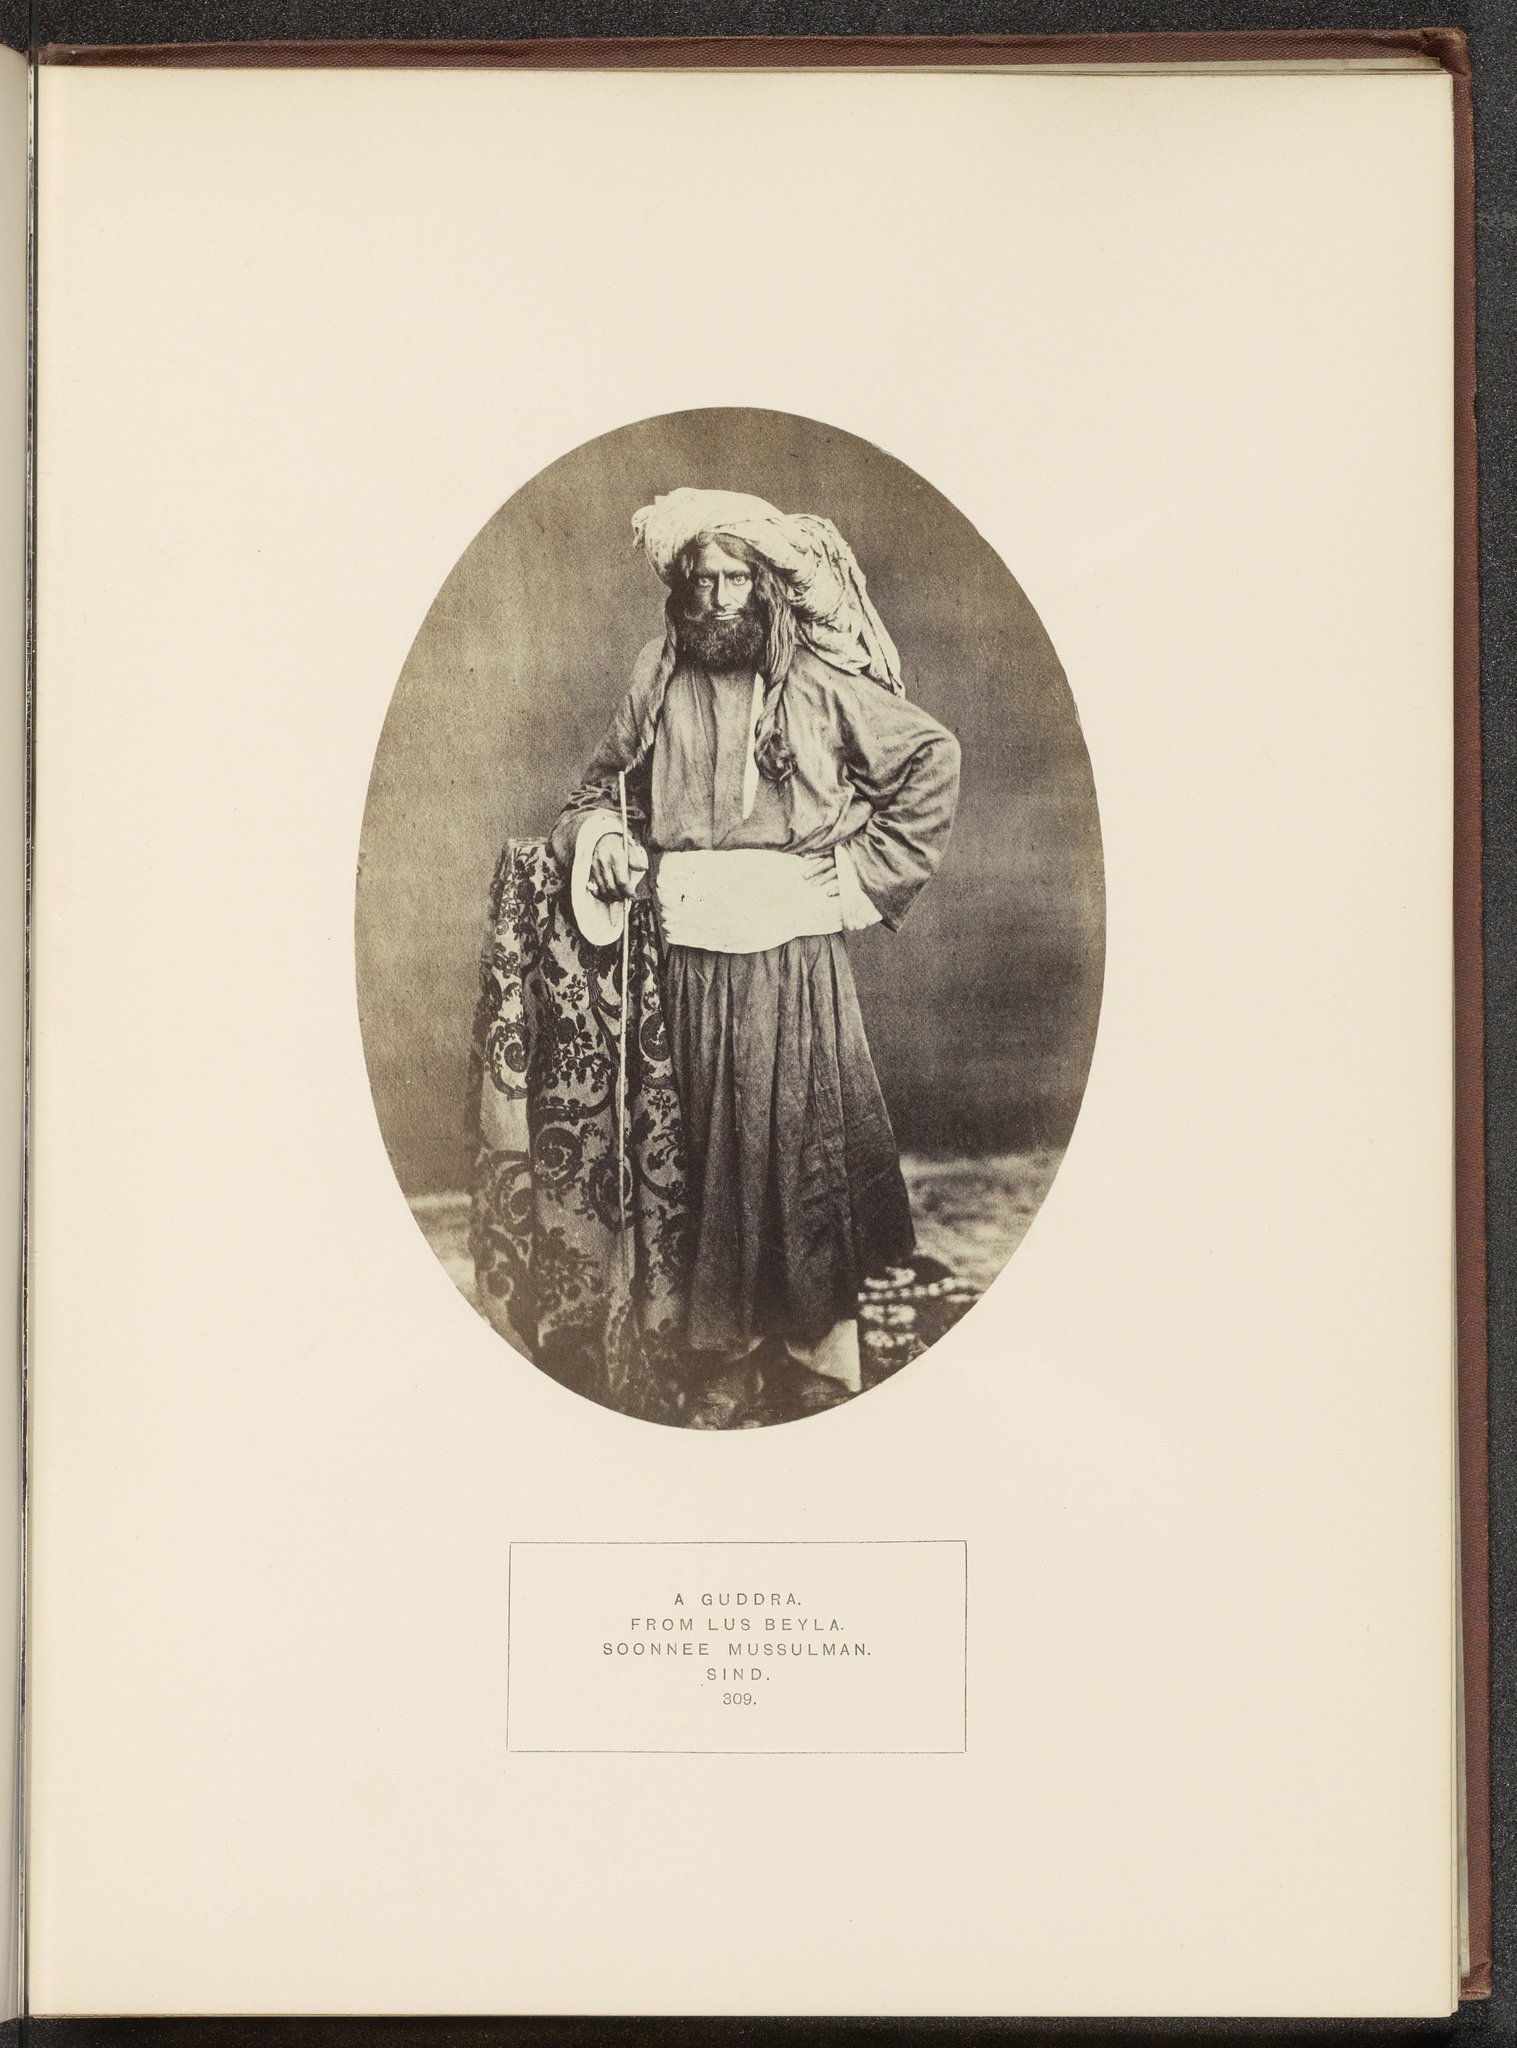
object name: photograph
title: Portrait of an unknown man from Lasbela, Balochistan, Pakistan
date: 1862-1872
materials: photographic support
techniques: albumen print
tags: head-gear: turban, human races; peoples; nationalities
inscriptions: inscription, number: ‘309.’